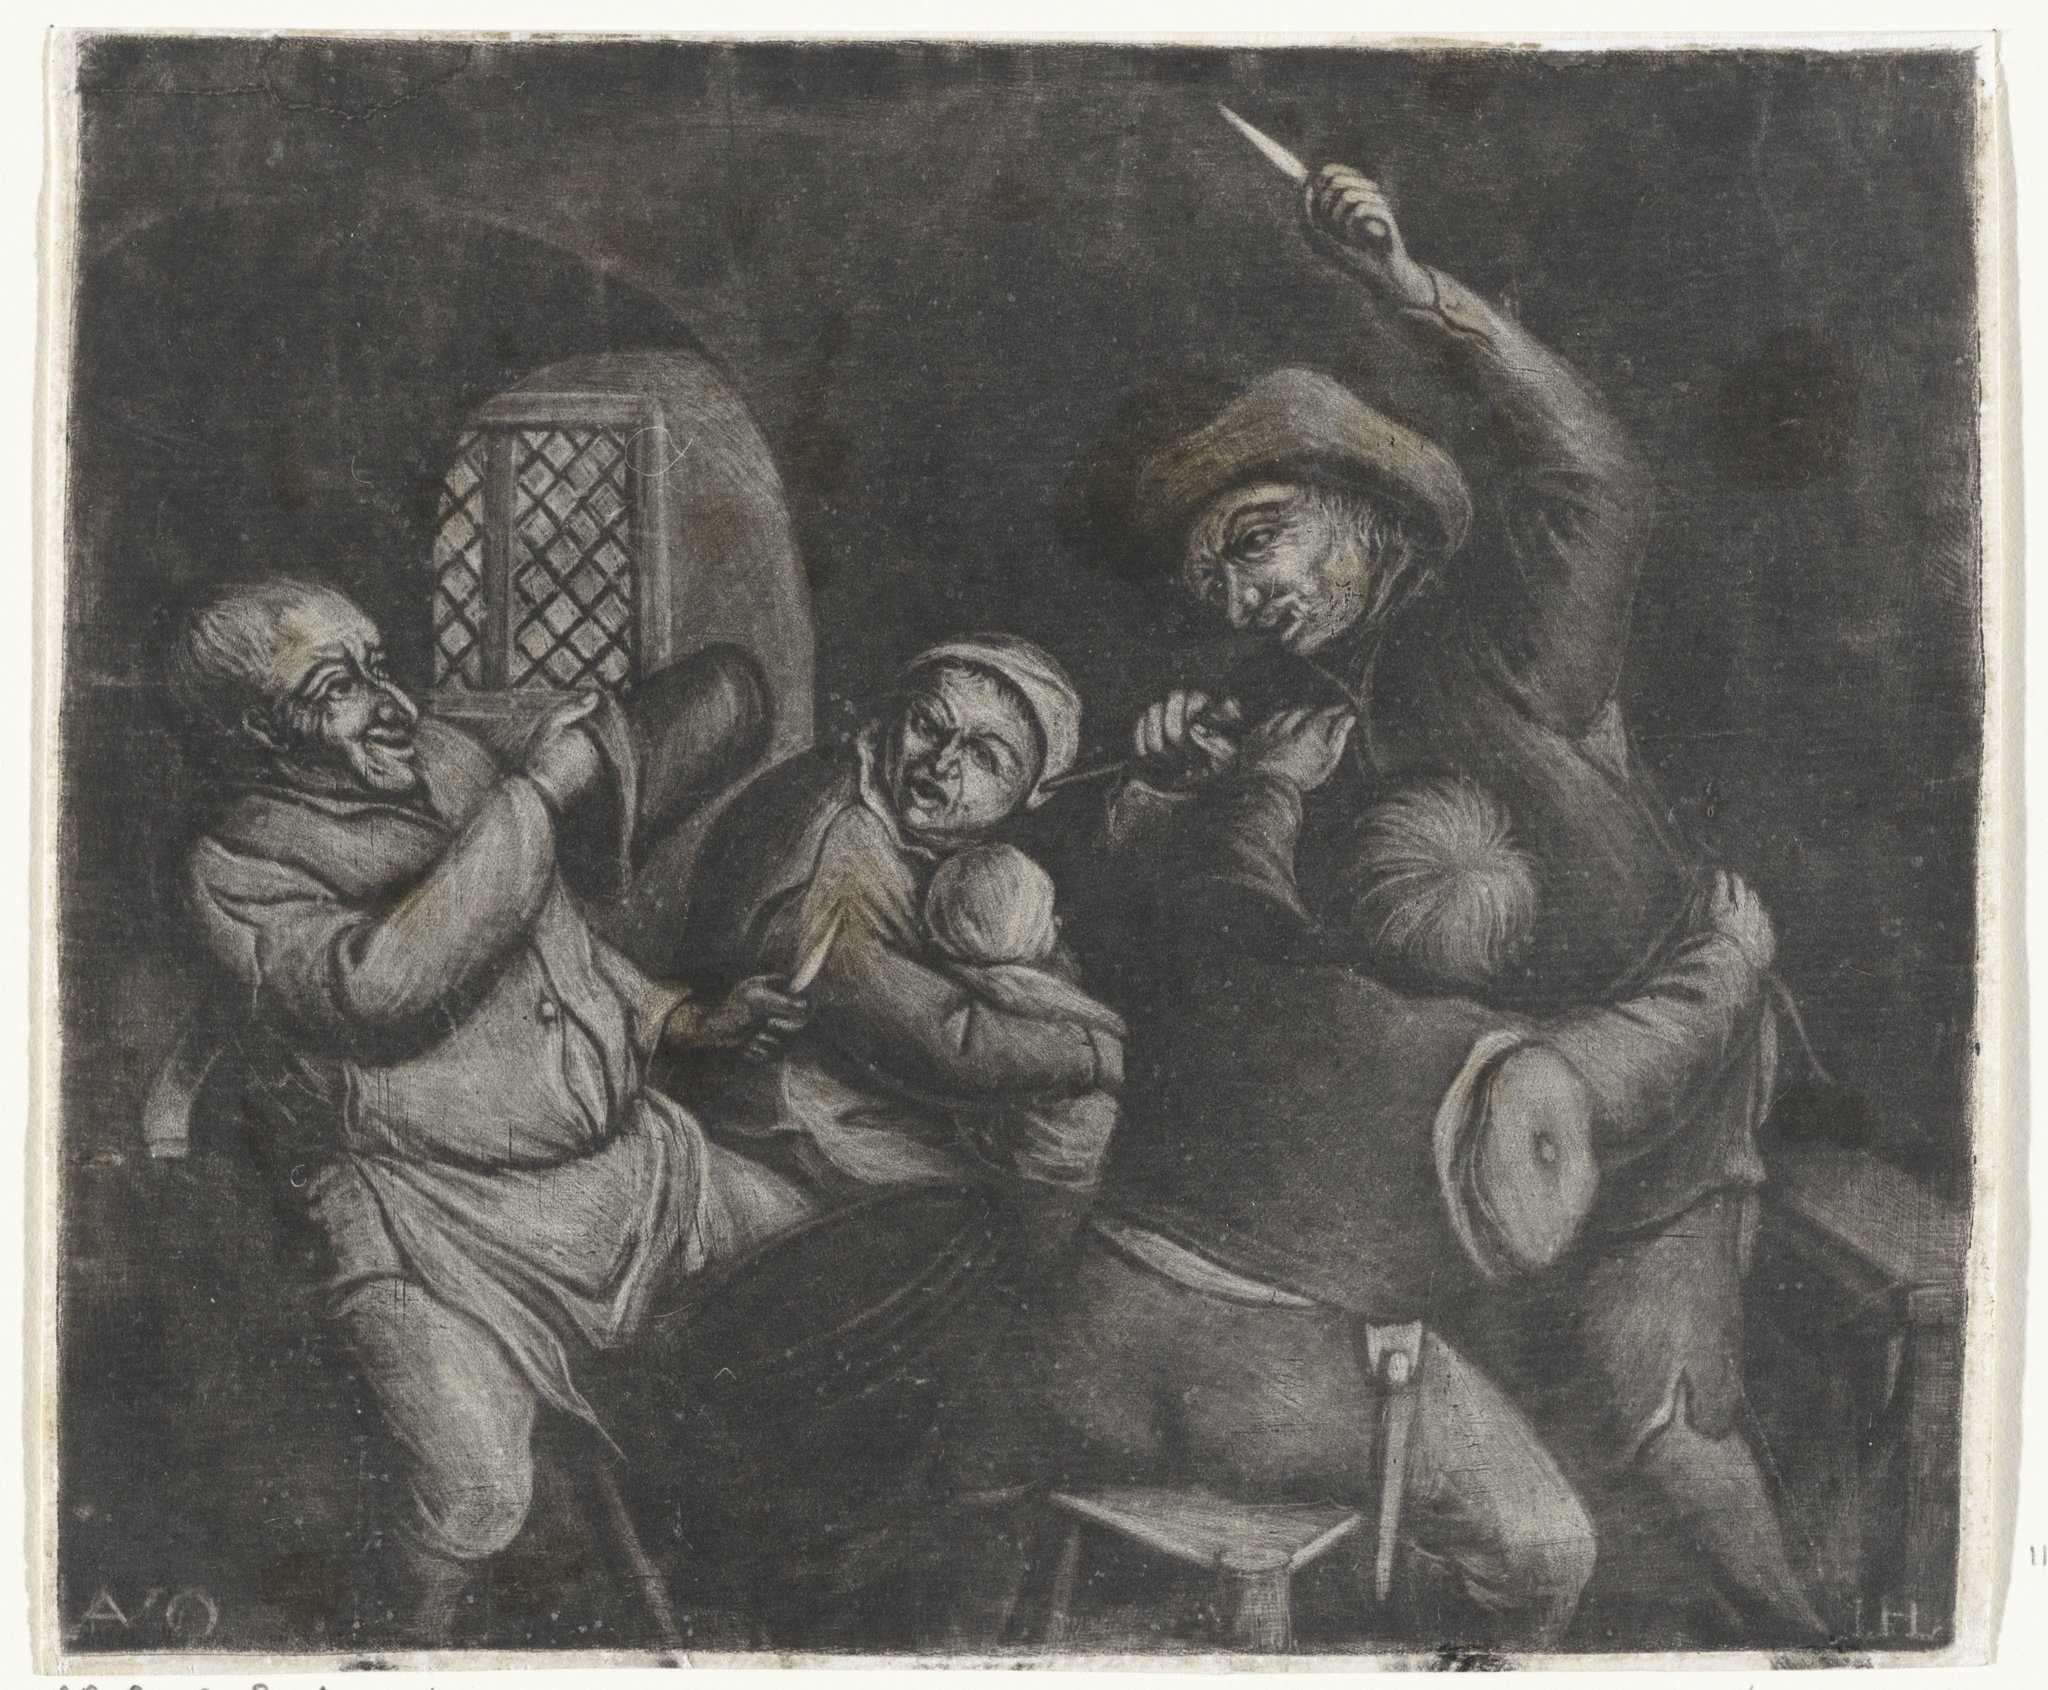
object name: print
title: Vechtende mannen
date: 1723-1789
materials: paper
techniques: mezzotint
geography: dordrecht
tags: inn, coffee-house, public house, etc., fighting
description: In een herberg probeert een man een andere man aan te vallen met een mes, een derde houdt hem tegen. Een vrouw met een kind in de armen kijkt toe.